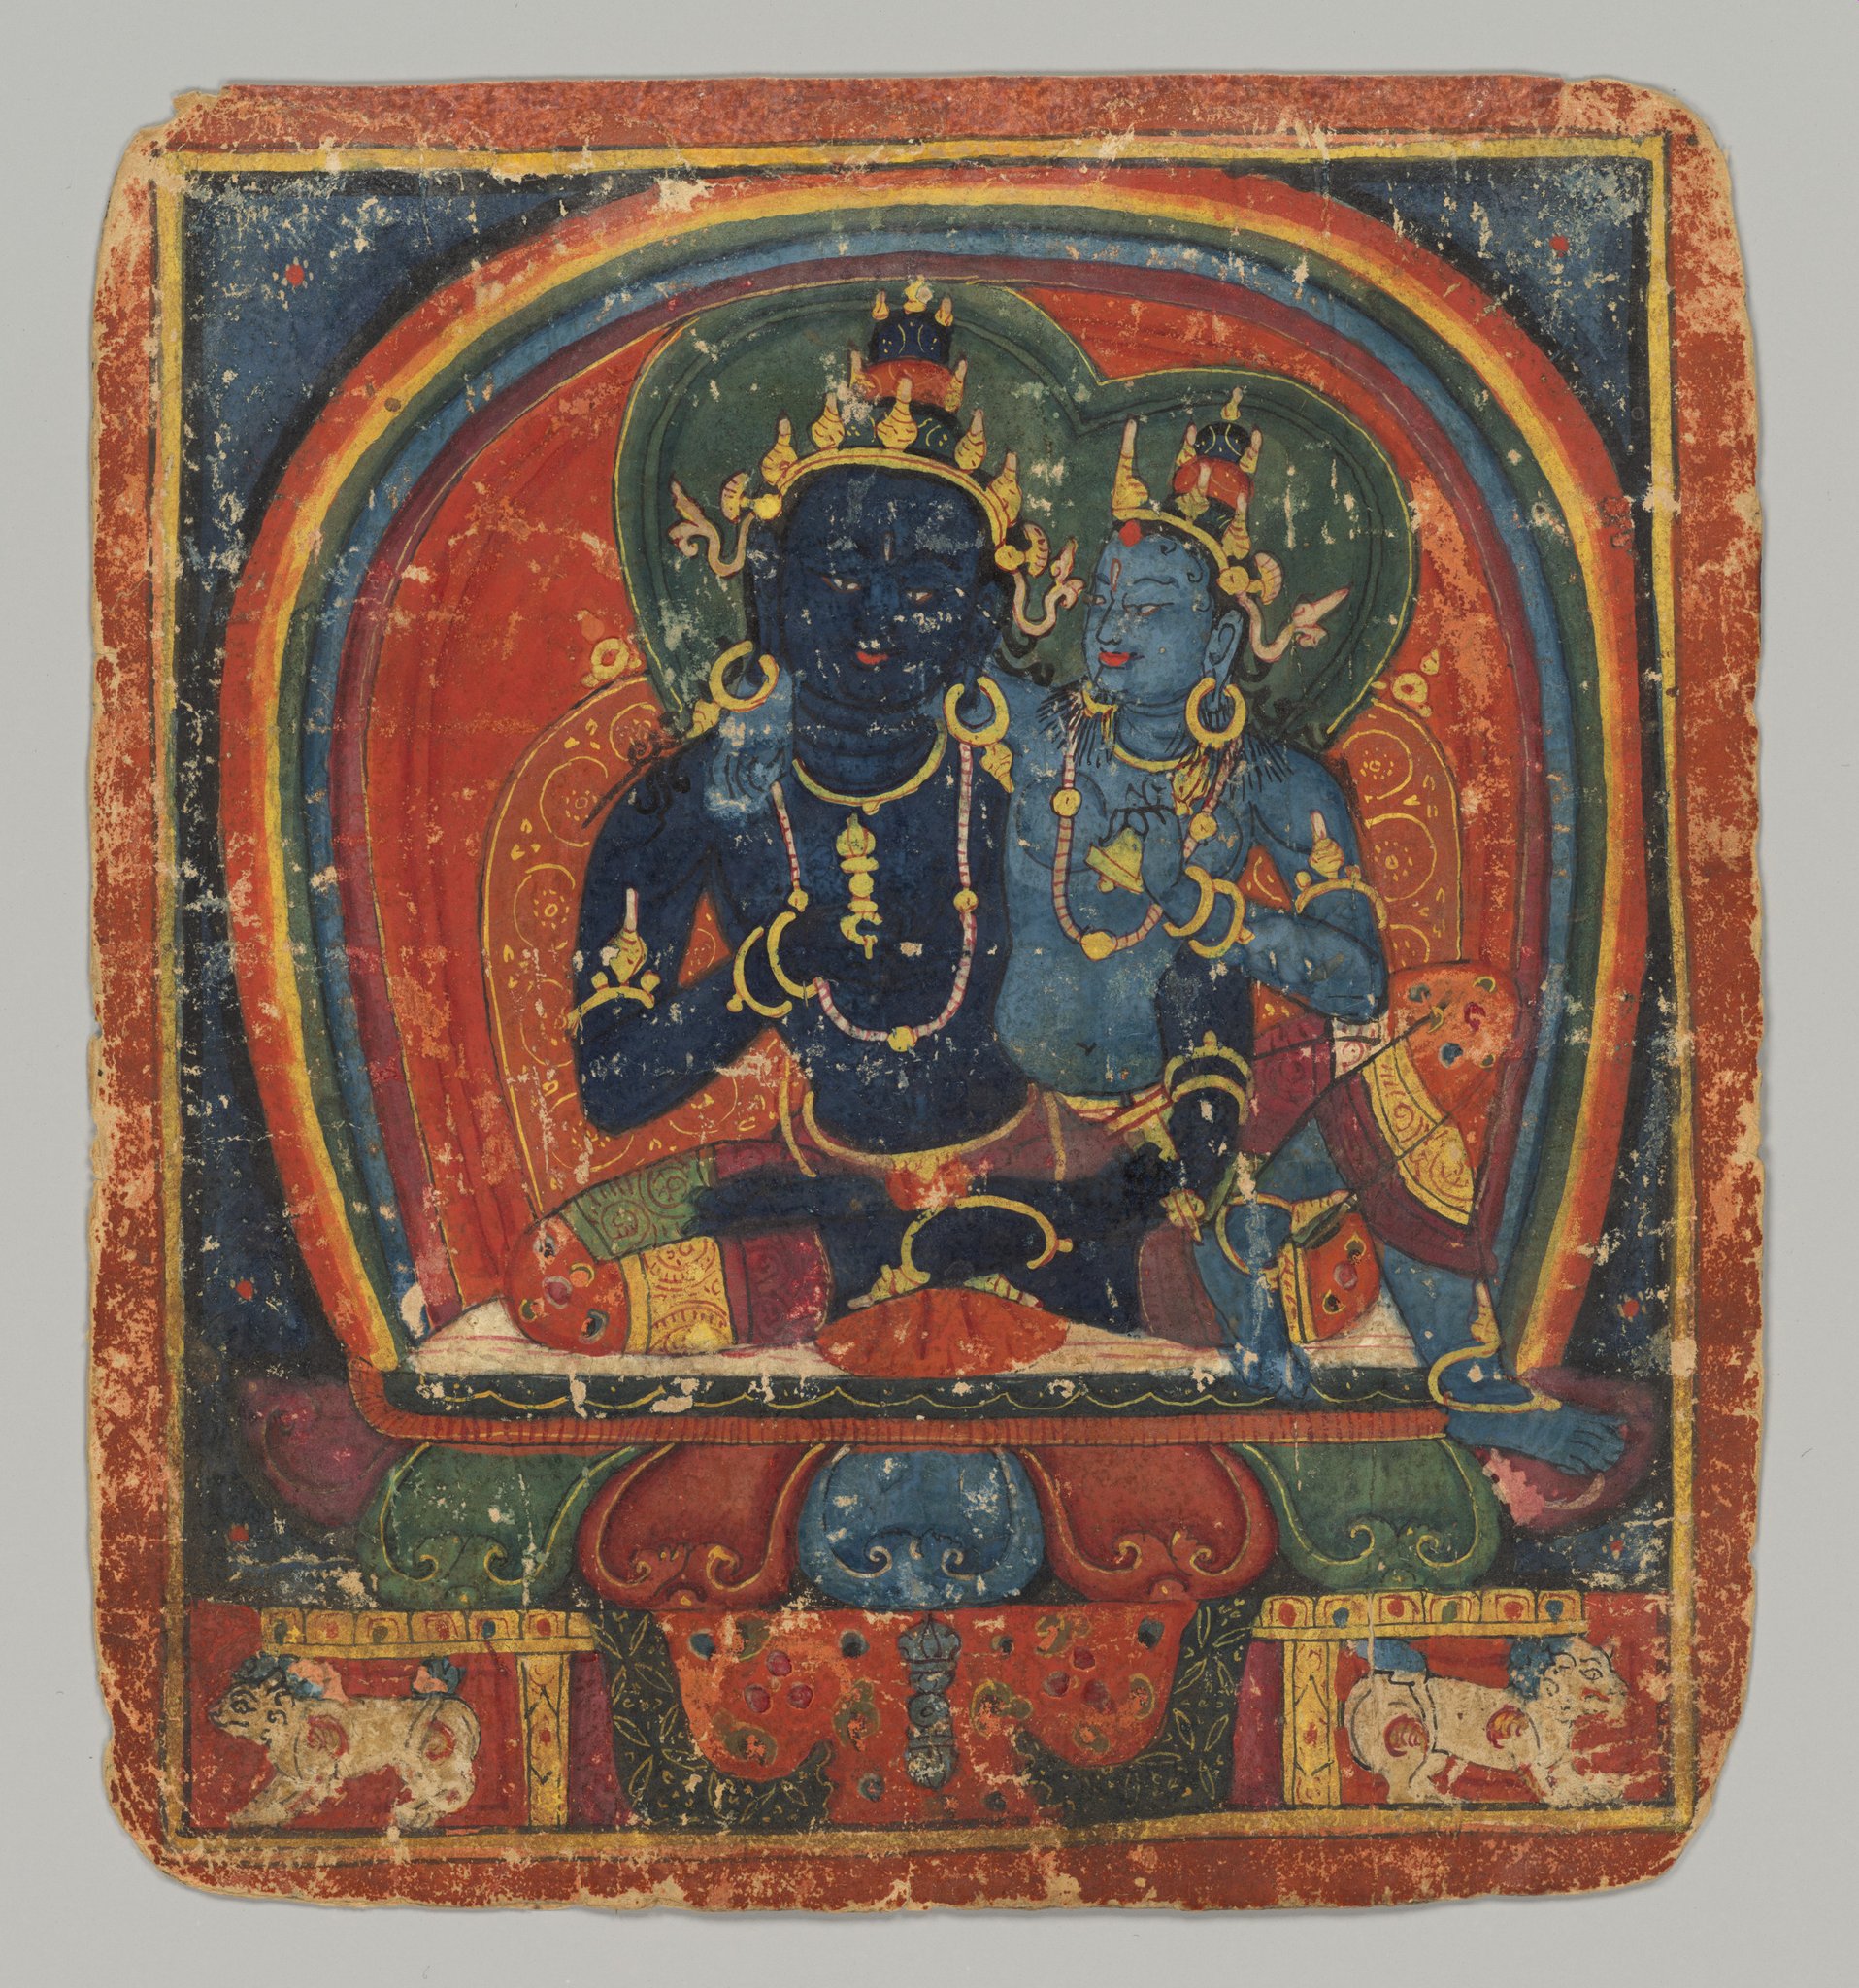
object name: initiation card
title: Initiation Card (Tsakalis): Akshobya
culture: tibetan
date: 1401-1433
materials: paper, watercolor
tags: buddhism,bodhisattvas,buddha,deities